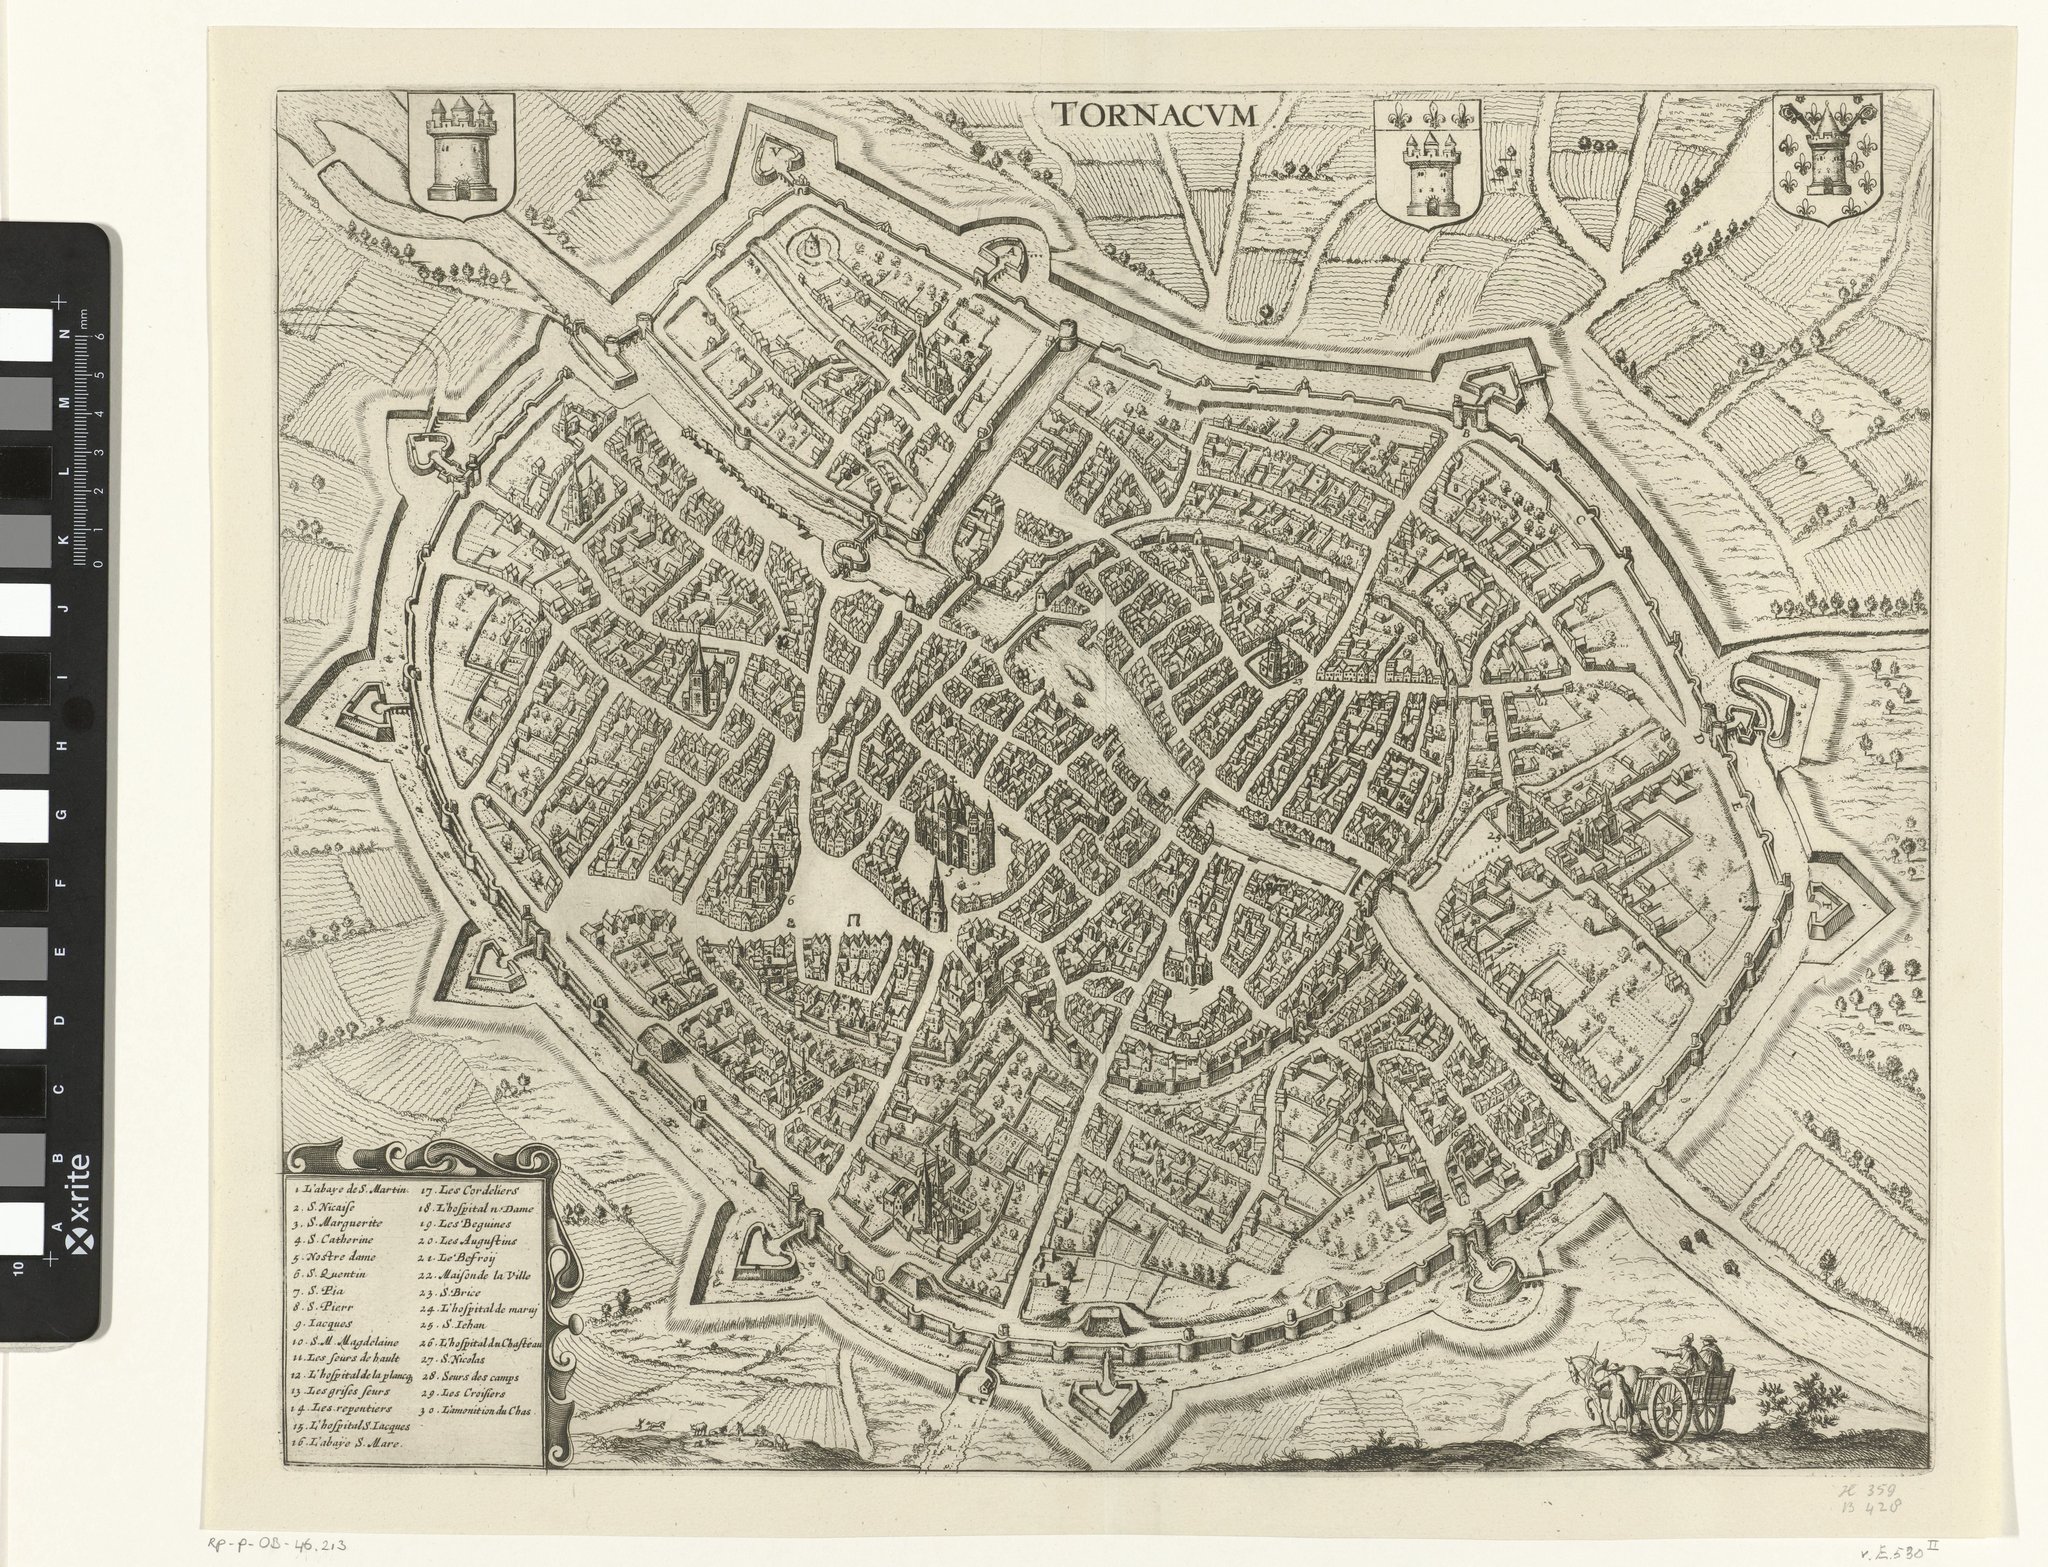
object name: book illustration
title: Tornacum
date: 1588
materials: paper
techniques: etching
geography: amsterdam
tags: maps of cities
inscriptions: collector's mark: Lugt 2228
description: Kaart opgenomen in: Janssonius van Waesberge, Johannes. Tooneel der vermaarste koop-steden en handel-plaatsen van de geheele wereld. Amsterdam: Johannes Janssonius van Waesberge II, 1682. Eerste staat opgenomen in: Braun, Georg. Civitates orbis terrarum, 6 delen. Keulen: Peter von Brachel en Gottfried von Kempen, 1572-1618, dl. IV (1588).